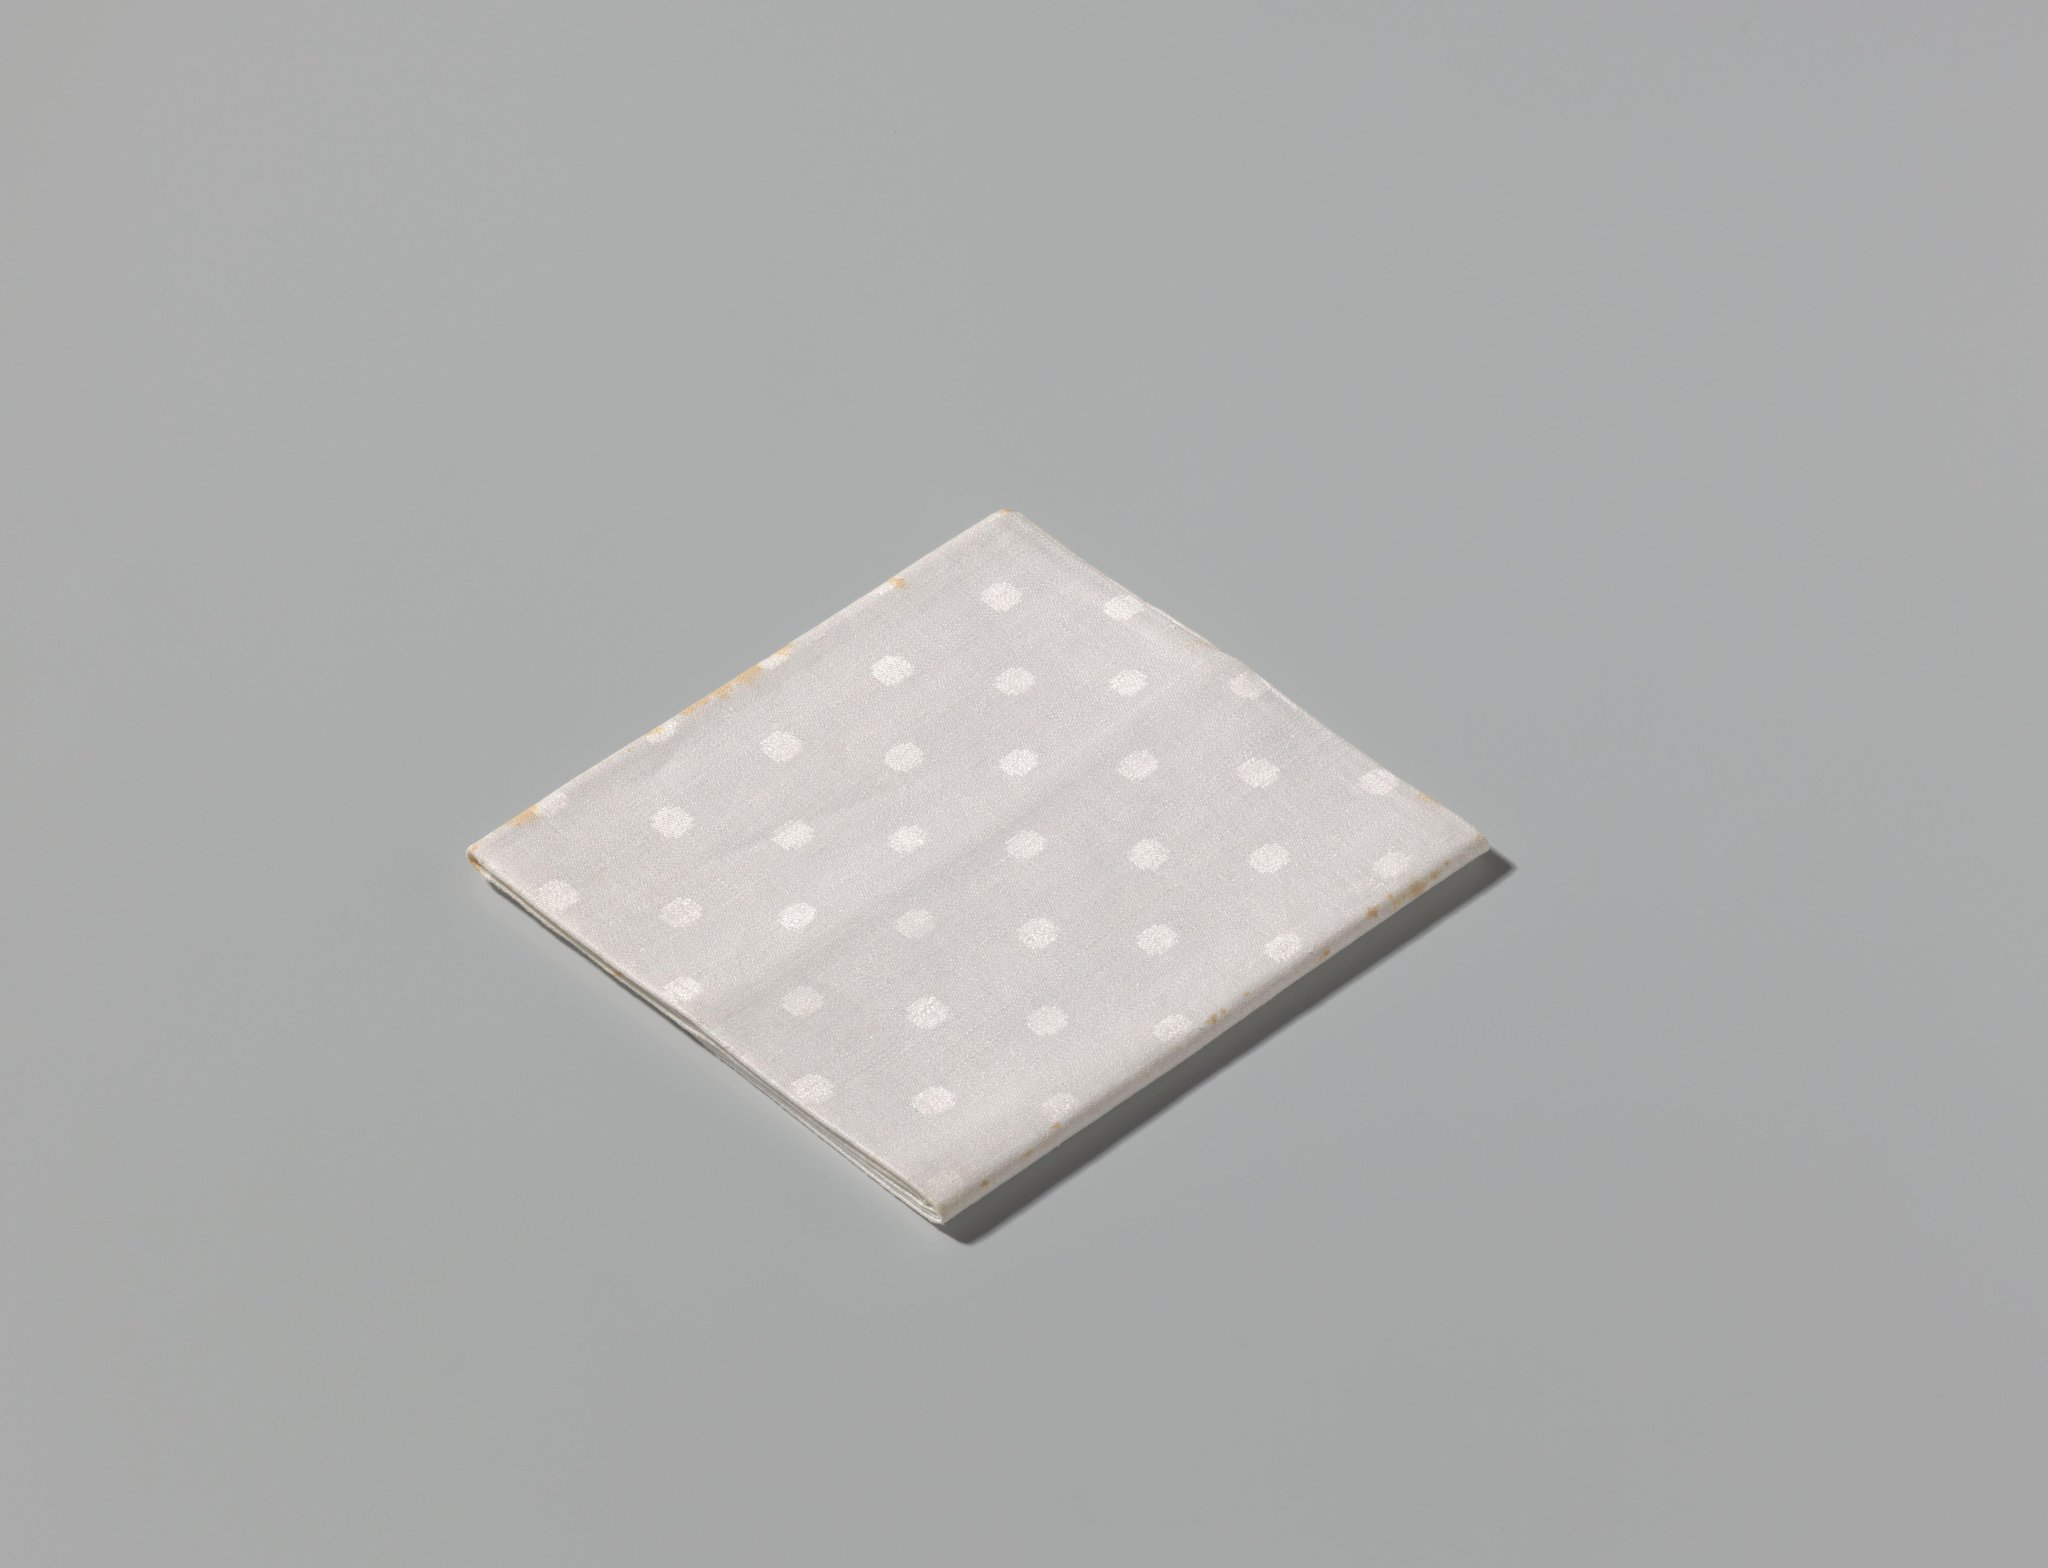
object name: towel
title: Handdoek van wit linnen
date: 1825-1875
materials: linen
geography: netherlands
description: Wit linnen handdoek met een 'moezen' patroon, merk HK WH 2oonl.